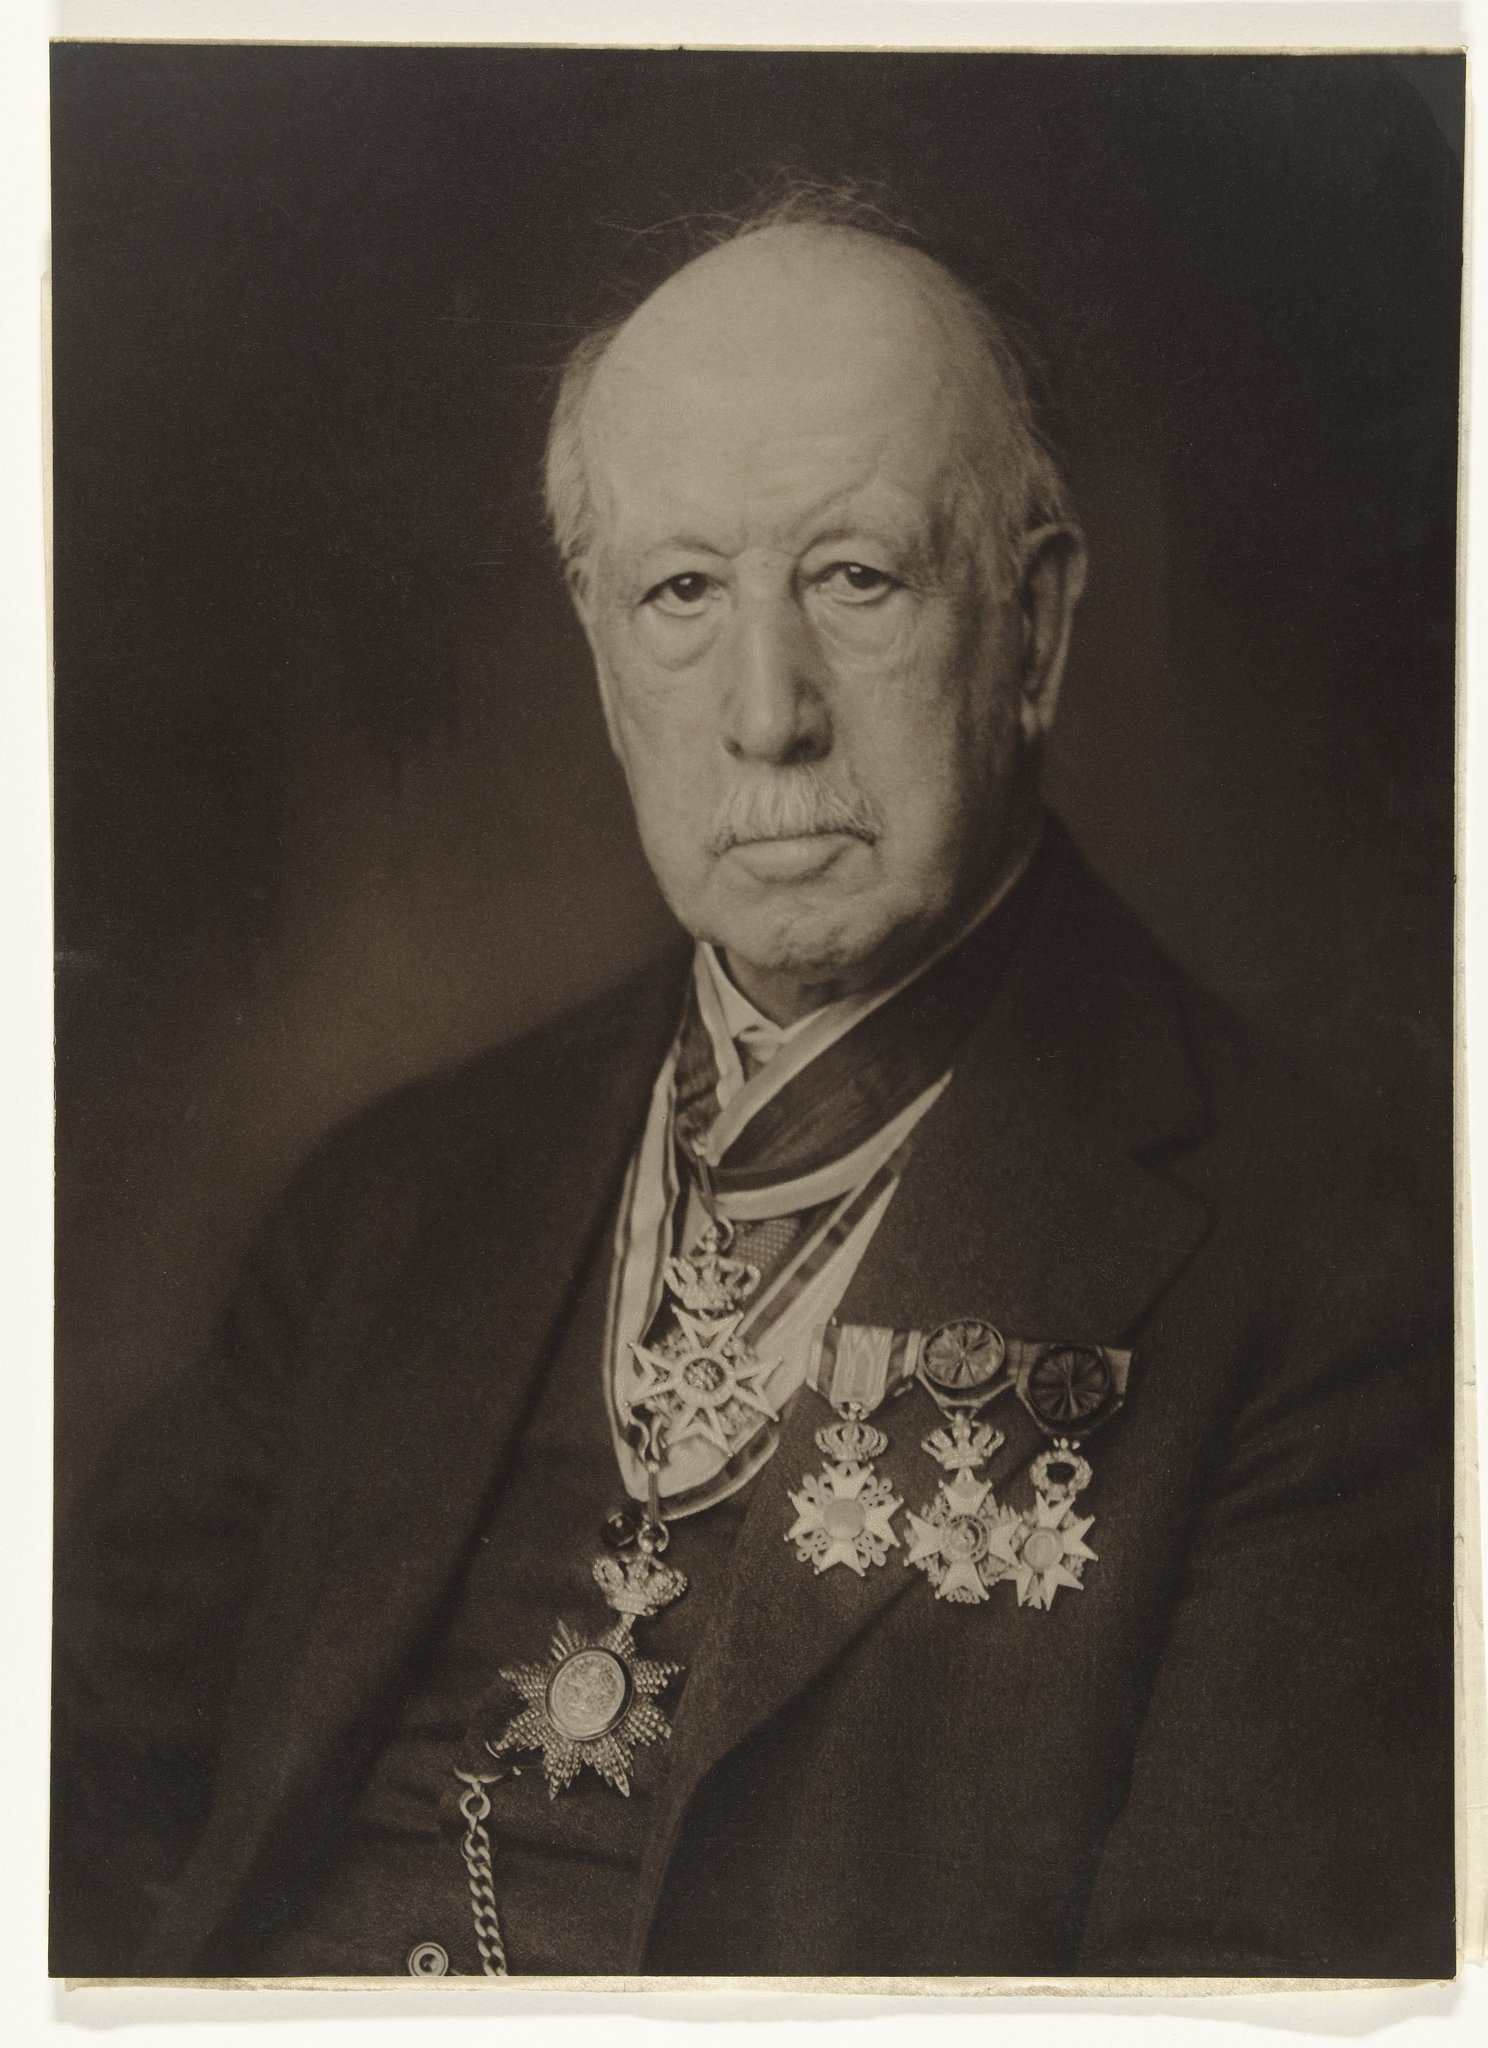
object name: photograph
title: Portret van de Amsterdamse wethouder Theodore Felix Albert Delprat (1851-1931)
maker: jacob merkelbach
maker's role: fotograaf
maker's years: 1877-1942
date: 1930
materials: cardboard, paper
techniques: carbon print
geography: amsterdam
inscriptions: annotation: ‘Kooldruk wethouder (A'dam) Delprat, foto J. Merkelbach’